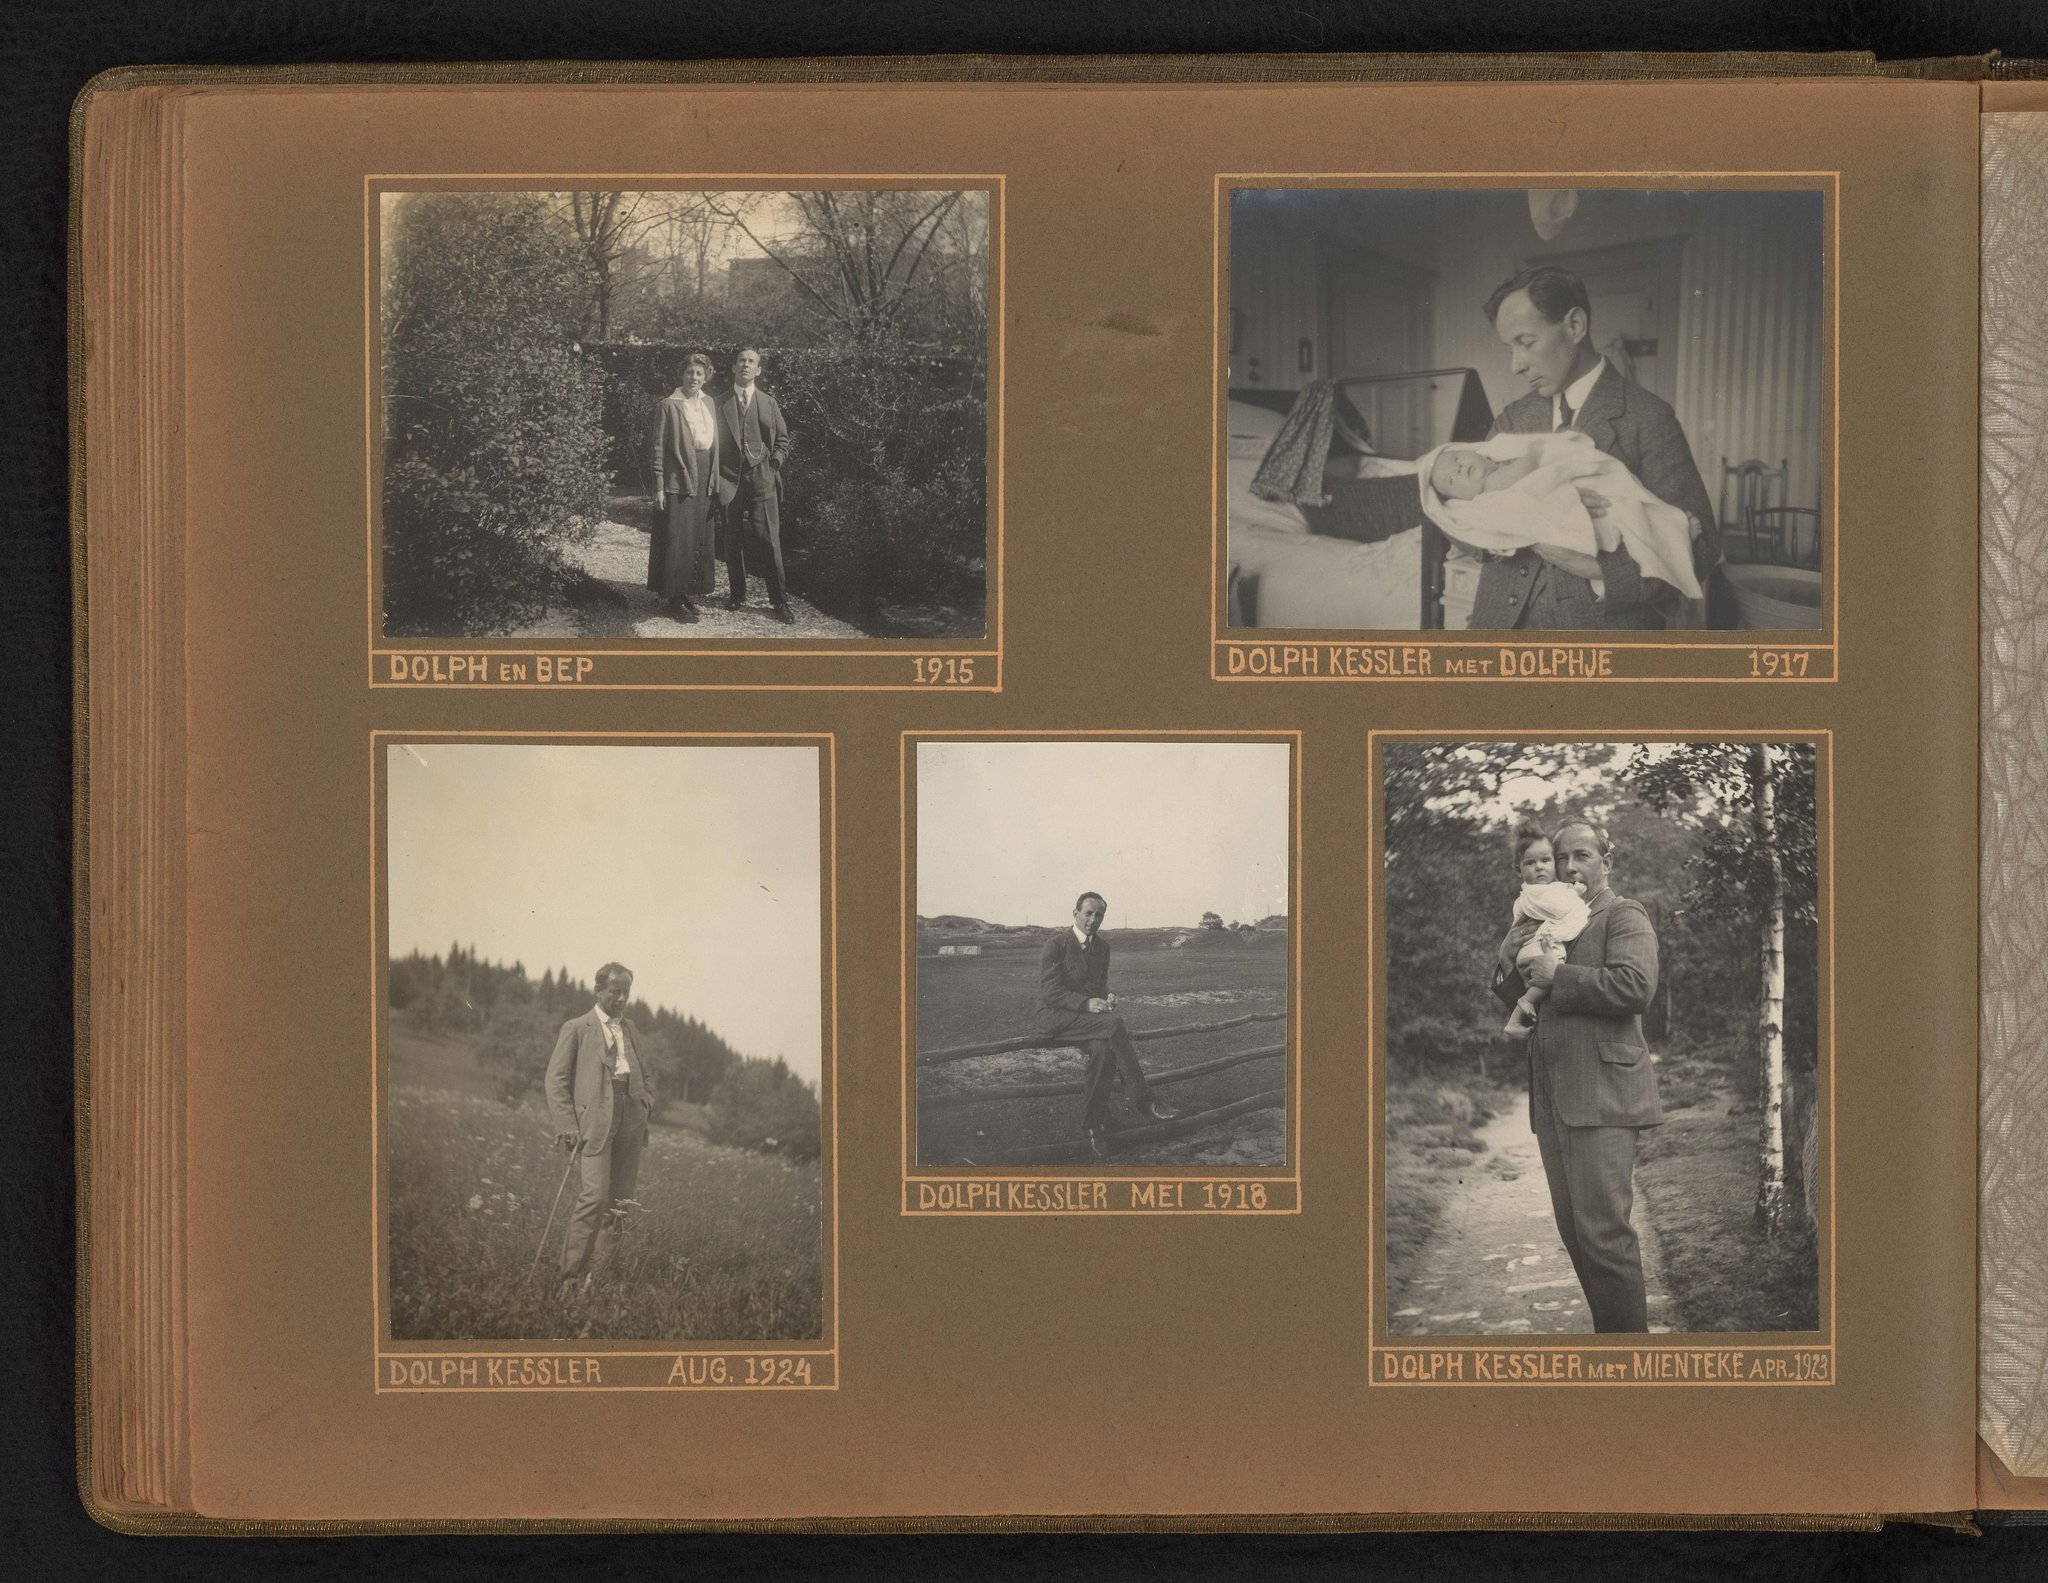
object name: photograph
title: Dolph Kessler met zijn vrouw Bep, en kinderen Dolph en Miente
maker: Anonymous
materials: paper, cardboard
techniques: gelatin silver print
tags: draughtsman, batavia, geldolph adriaan kessler (dolph), historical persons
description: Deze foto's zijn onderdeel van een album.